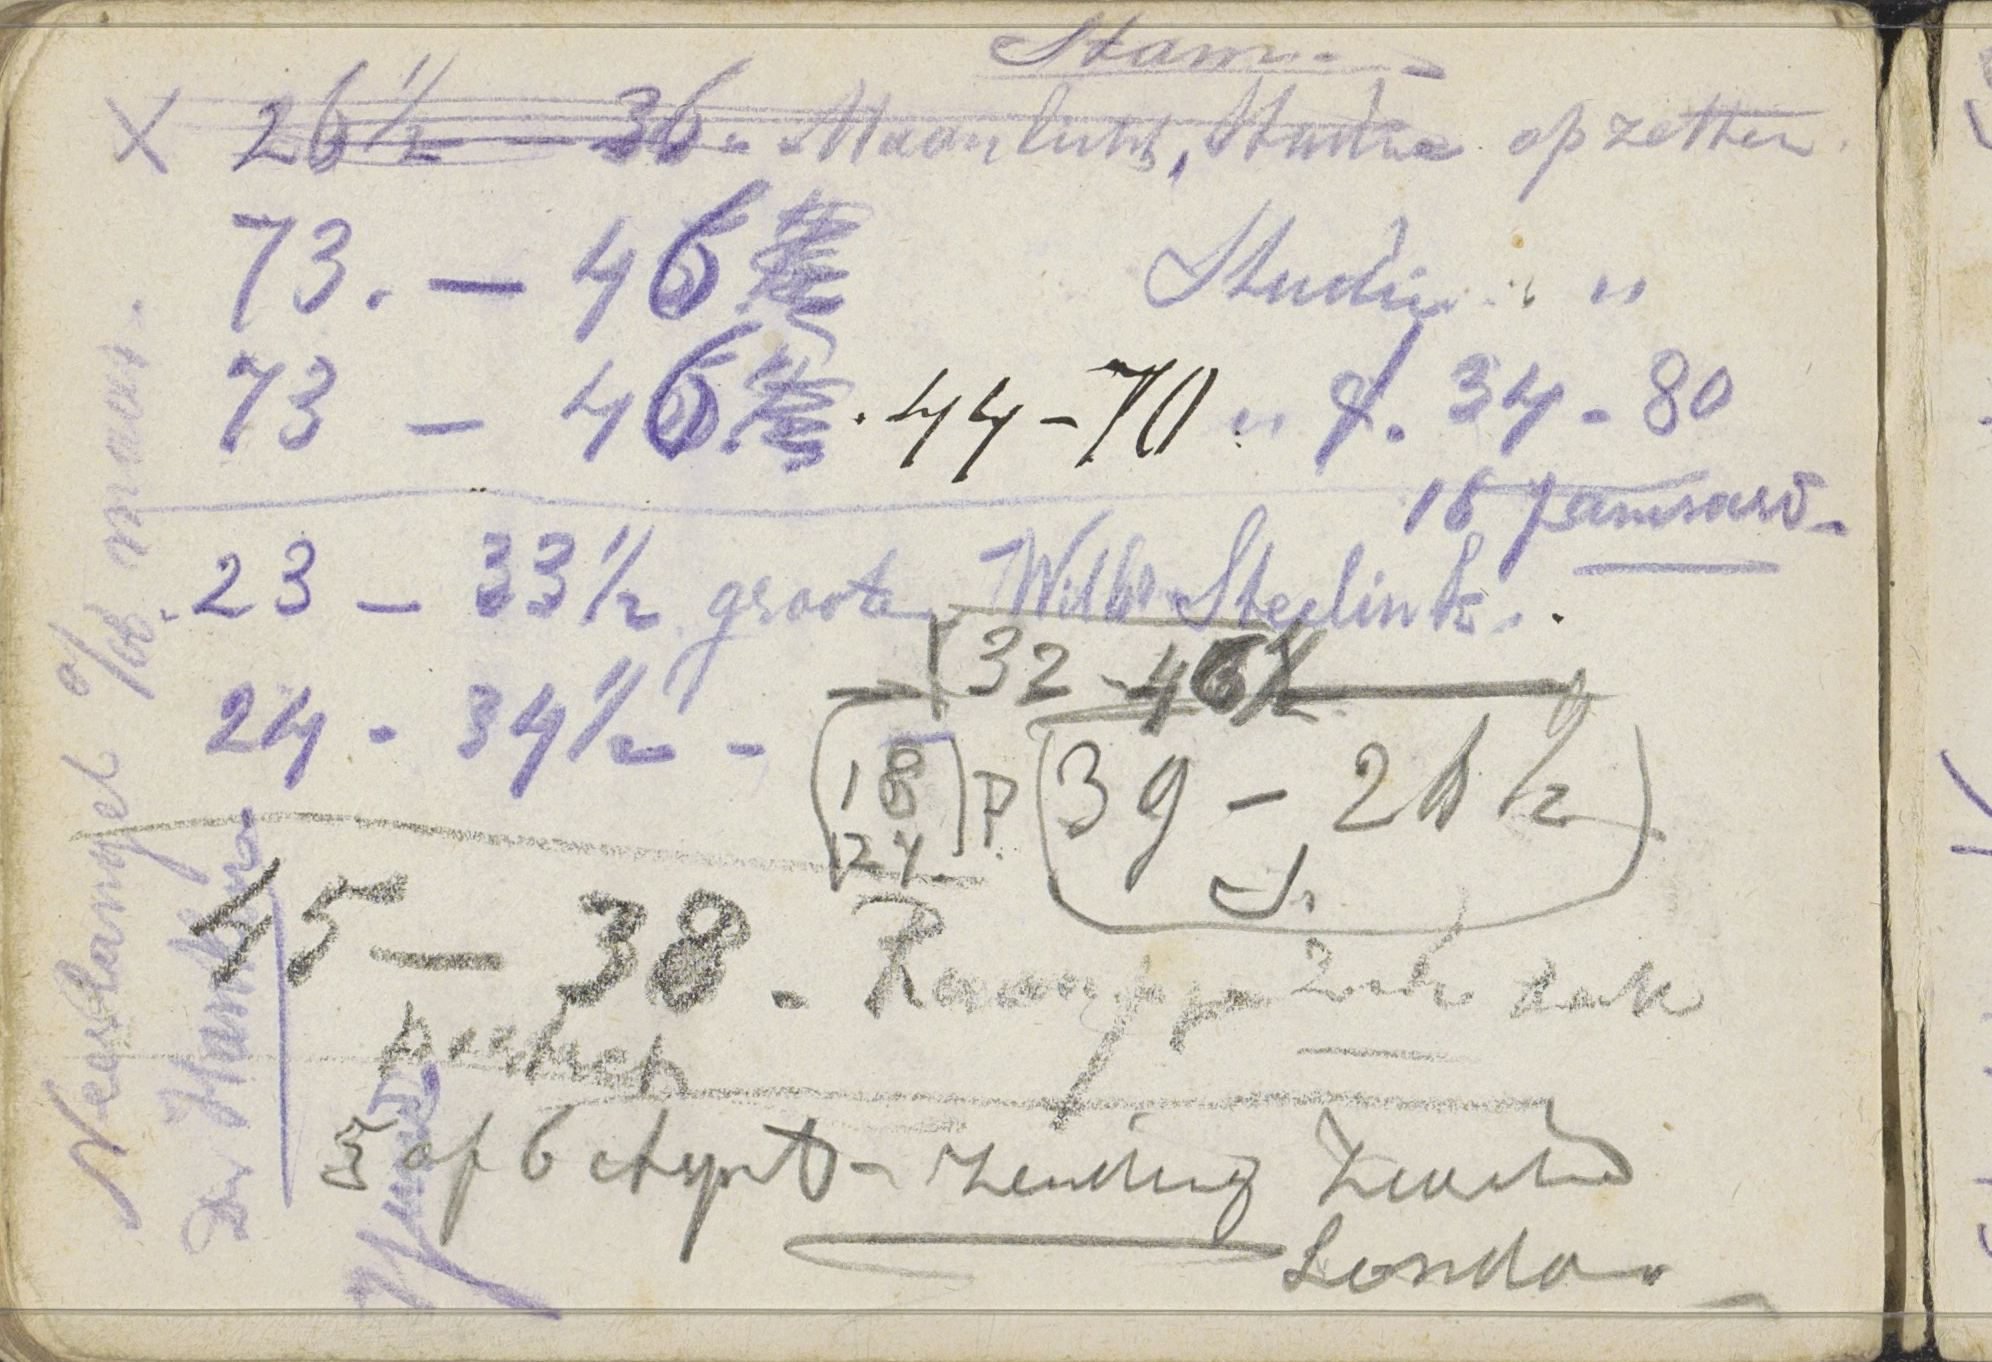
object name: sketchbook leaf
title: Notities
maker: willem cornelis rip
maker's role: draughtsman, painter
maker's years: 1856-1922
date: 1905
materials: paper, pencil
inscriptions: annotation: ‘[...]’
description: Blad 42 recto uit een schetsboek met 42 bladen.